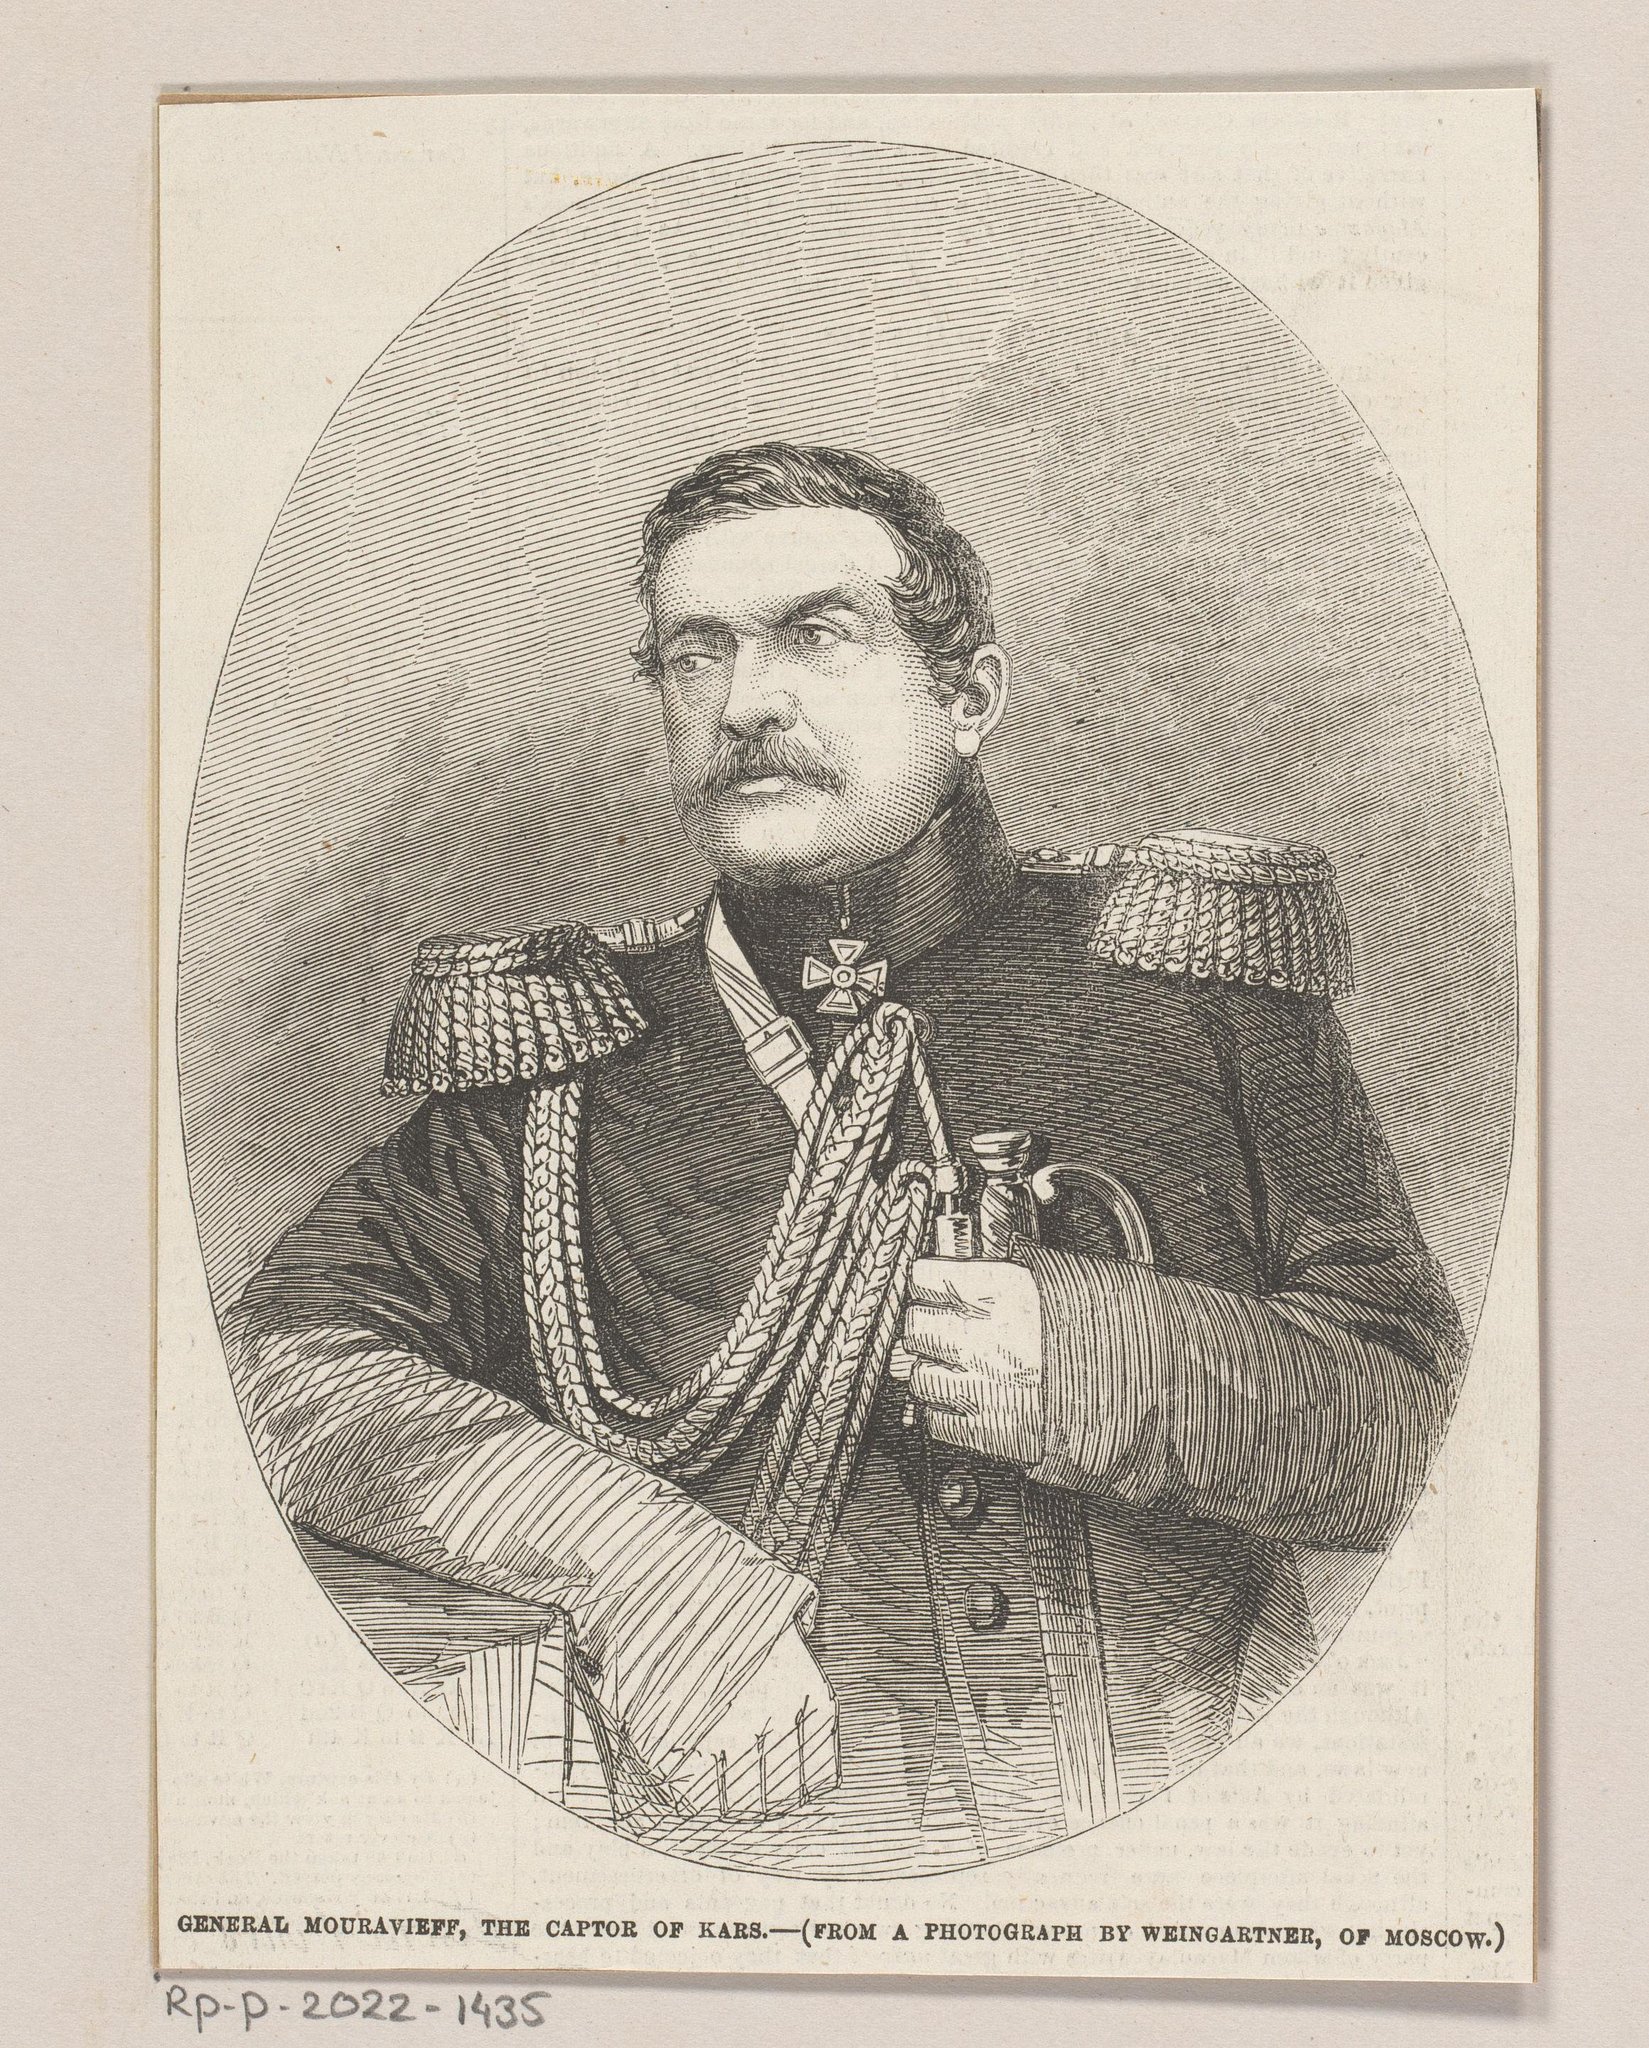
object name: print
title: Portret van Nikolay Muravyov-Karsky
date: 1856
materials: paper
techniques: letterpress printing, snipping, engraving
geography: moscow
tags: commander-in-chief, general, marshal, historical persons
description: Prent waarschijnlijk uit: The Illustrated Londen News 28 (1856), p. 484.